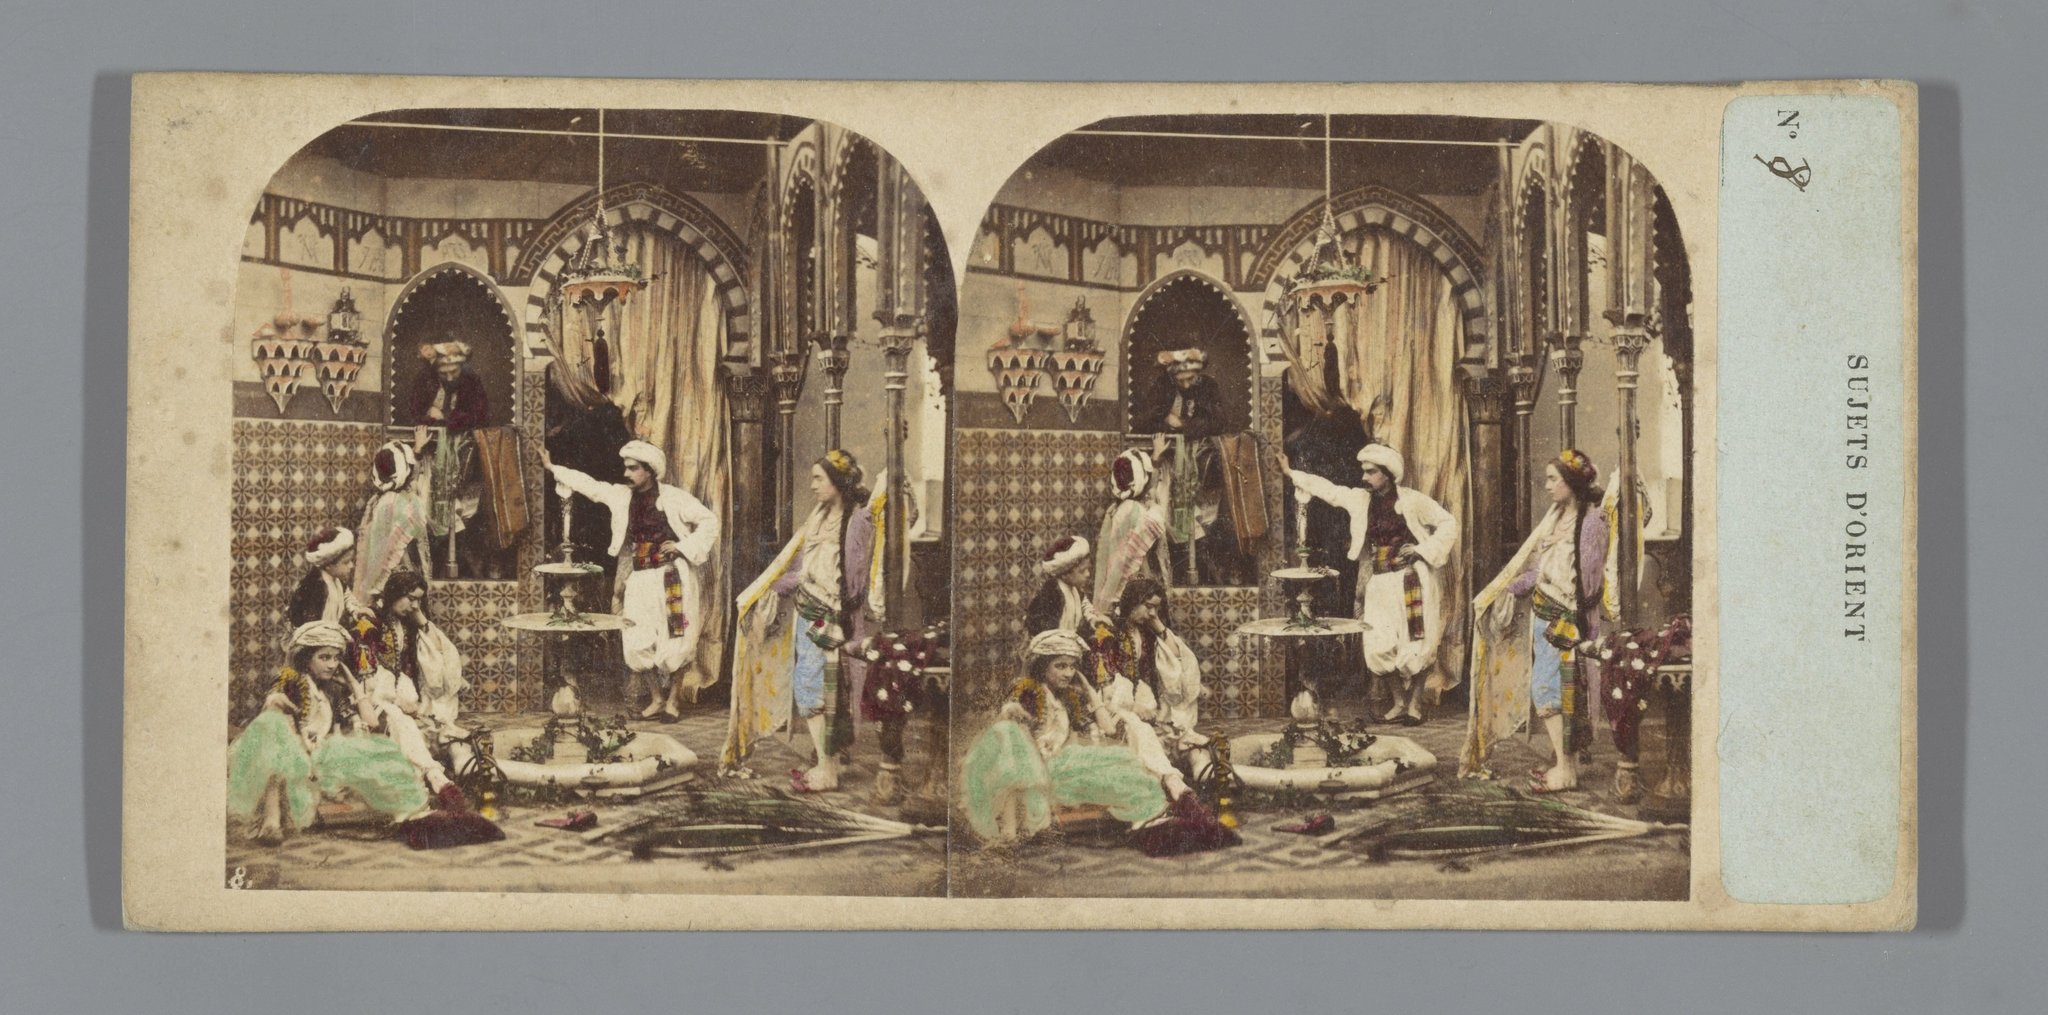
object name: stereograph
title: Sujets d'Orient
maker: Anonymous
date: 1850-1862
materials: cardboard, paper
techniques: albumen print, hand coloring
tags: ornamental fountain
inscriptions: number: ‘8’, retailer's mark: ‘Feldbrugge & Co./ Groningen’